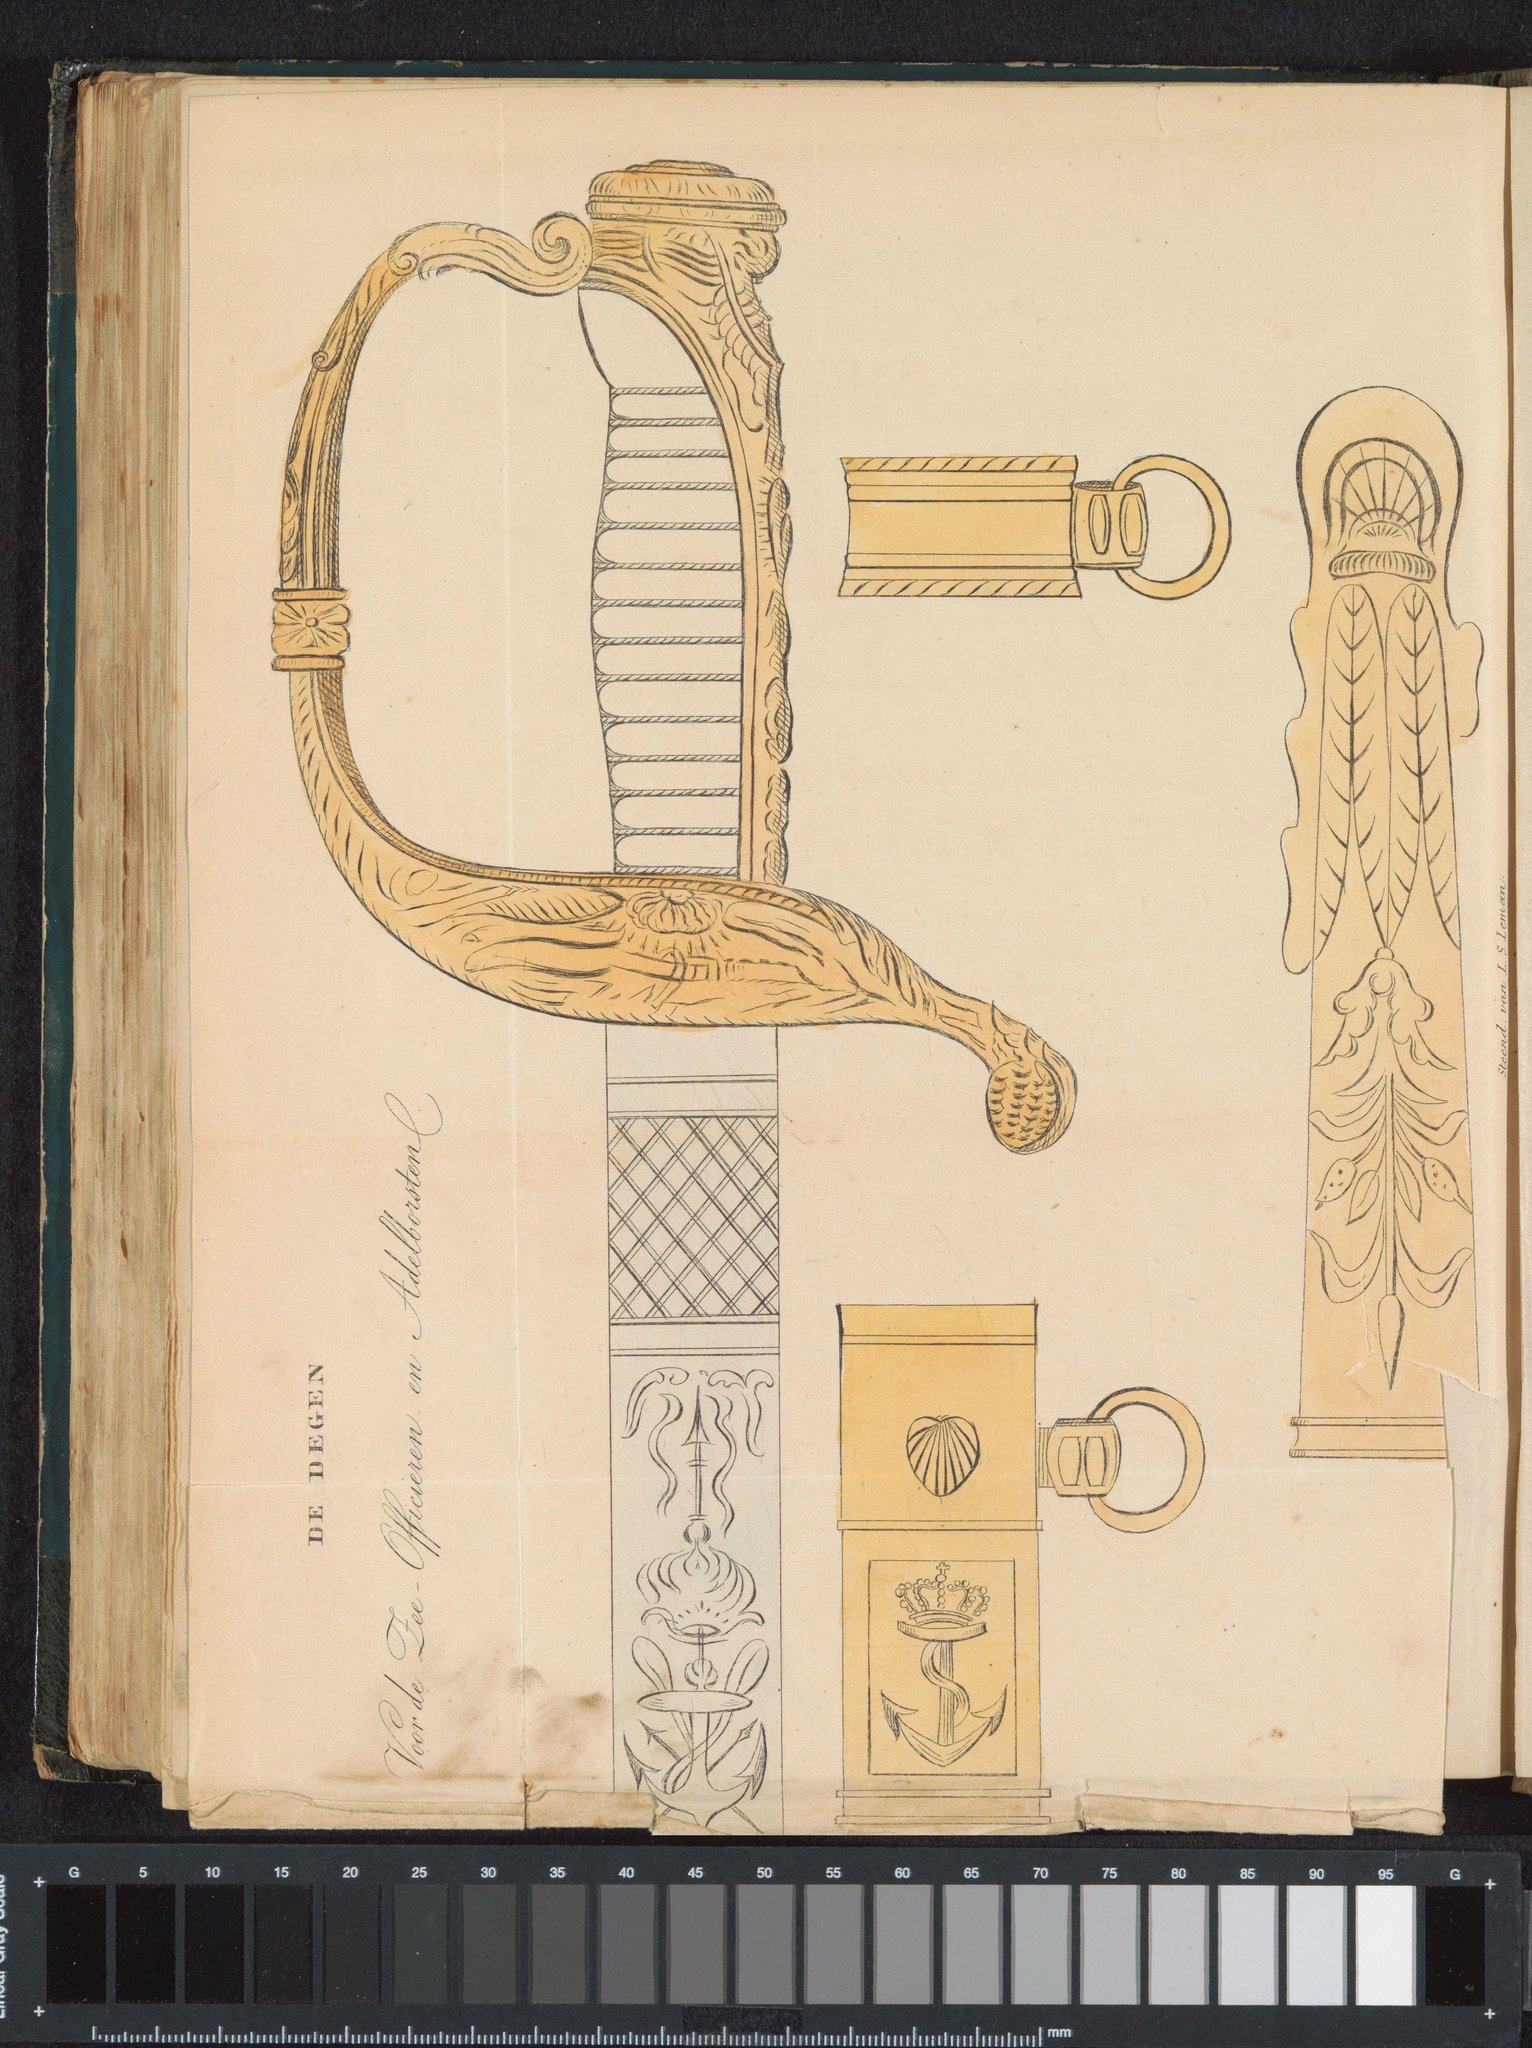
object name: book illustration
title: Degen voor de zeeofficieren en adelborsten van de Marine, 1845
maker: louis salomon leman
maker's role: steendrukker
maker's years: 1818-1889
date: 1845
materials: paper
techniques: hand coloring, lithograph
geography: amsterdam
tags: (military) uniforms, netherlands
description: De degen voor de zeeofficieren en adelborsten van de Marine. Illustratie in een boek uit 1845 over de uniformen en kledingstukken van de Nederlandse land-, zeemacht en schutterijen in Nederland en in de overzeese gebiedsdelen.